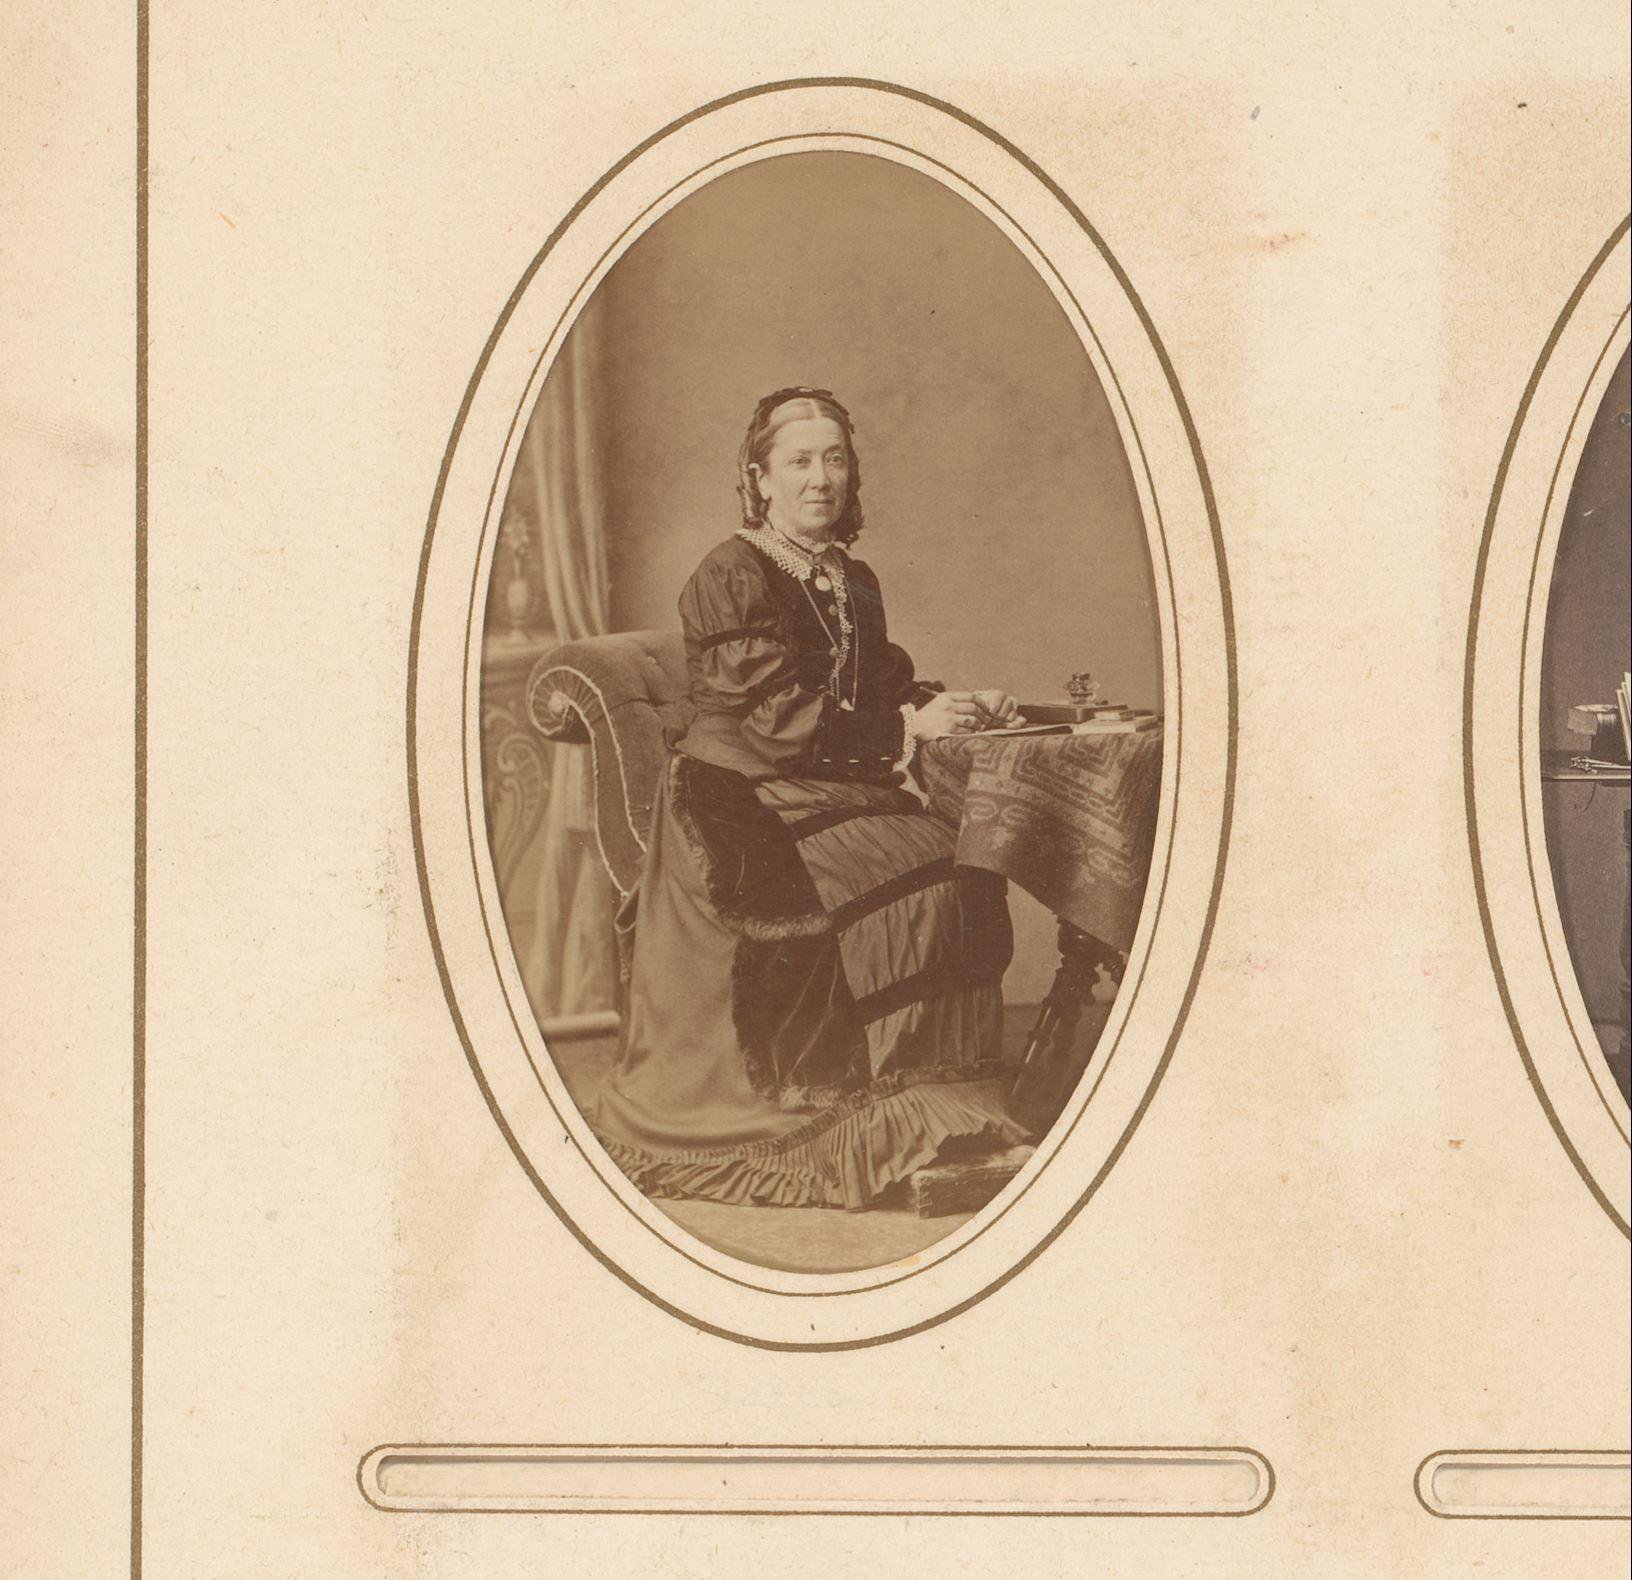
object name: album leaf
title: Portret van een vrouw, schrijvend aan een tafel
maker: john hunt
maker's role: fotograaf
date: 1870-1885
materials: cardboard, paper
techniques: albumen print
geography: sheerness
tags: historical persons - bb - woman, writing and letters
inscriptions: inscription: ‘UNDER DISTINGUISHED PATRONAGE/ JOHN HUNT/ SHEERNESS/ ESTABLISHED 1851’